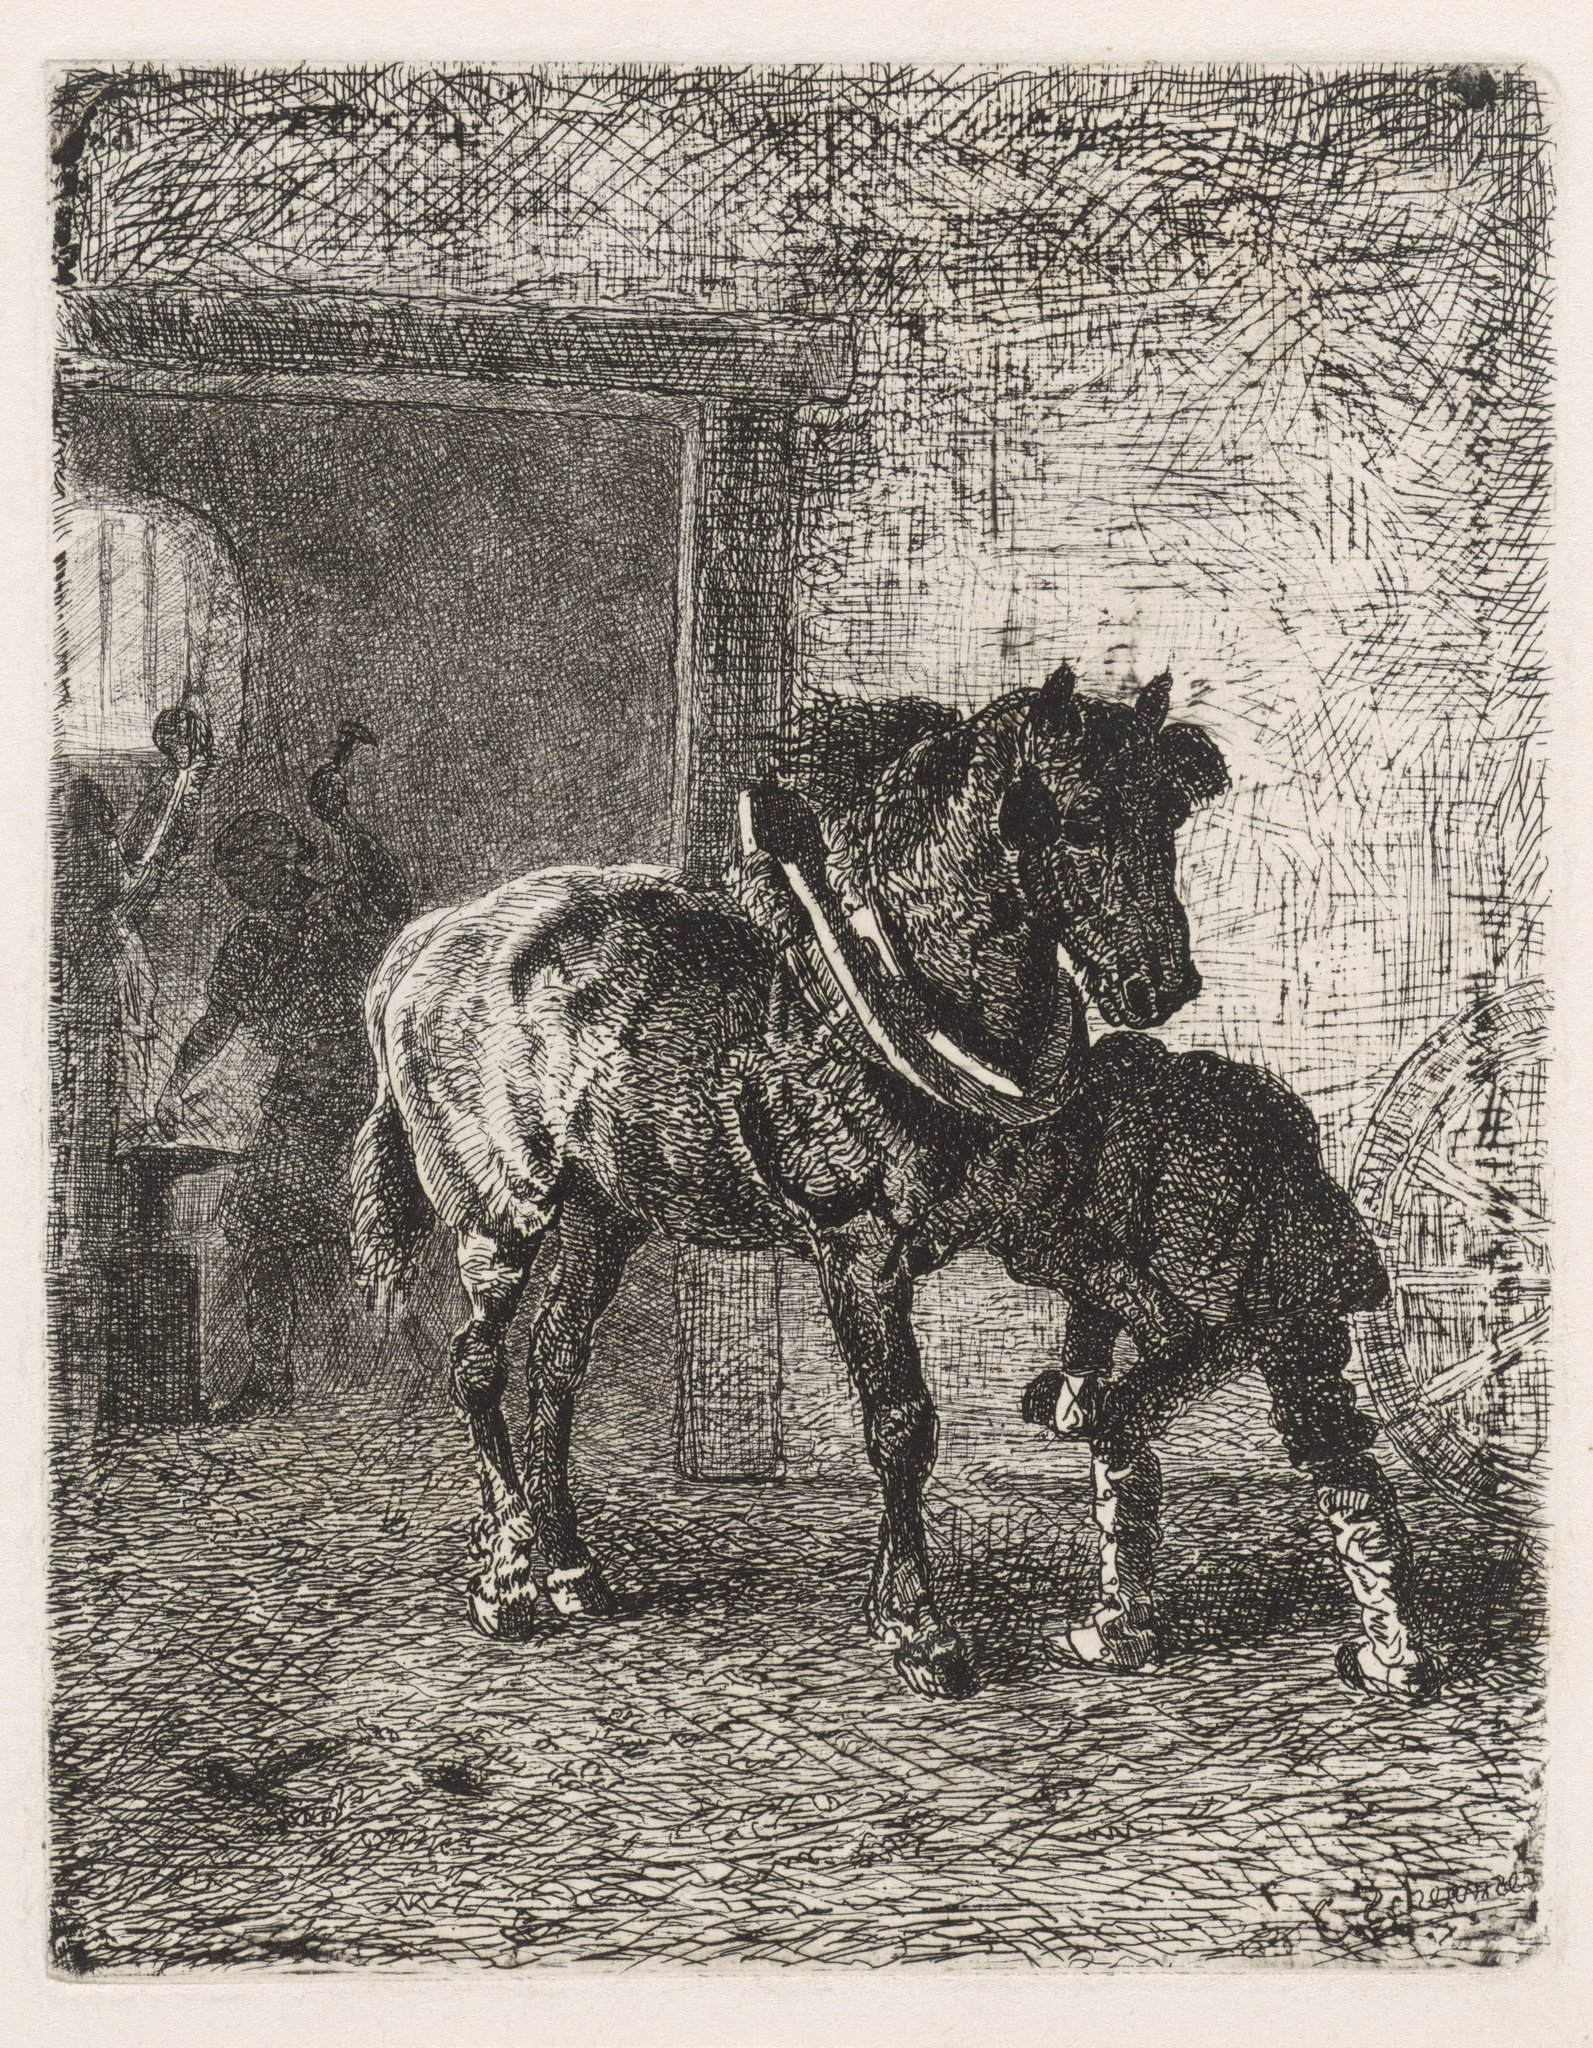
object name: print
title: Paard krijgt hoefijzers in een smederij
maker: cornelis albertus johannes schermer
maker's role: draughtsman, painter, print maker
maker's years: 1824-1915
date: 1839-1915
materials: paper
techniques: etching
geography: the hague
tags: farrier, shoeing-smith, horse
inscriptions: collector's mark: Lugt 2228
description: Vooraan beslaat een man de hoef van een paard. Achter hem is een smid in een smederij aan het werk bij een aambeeld.